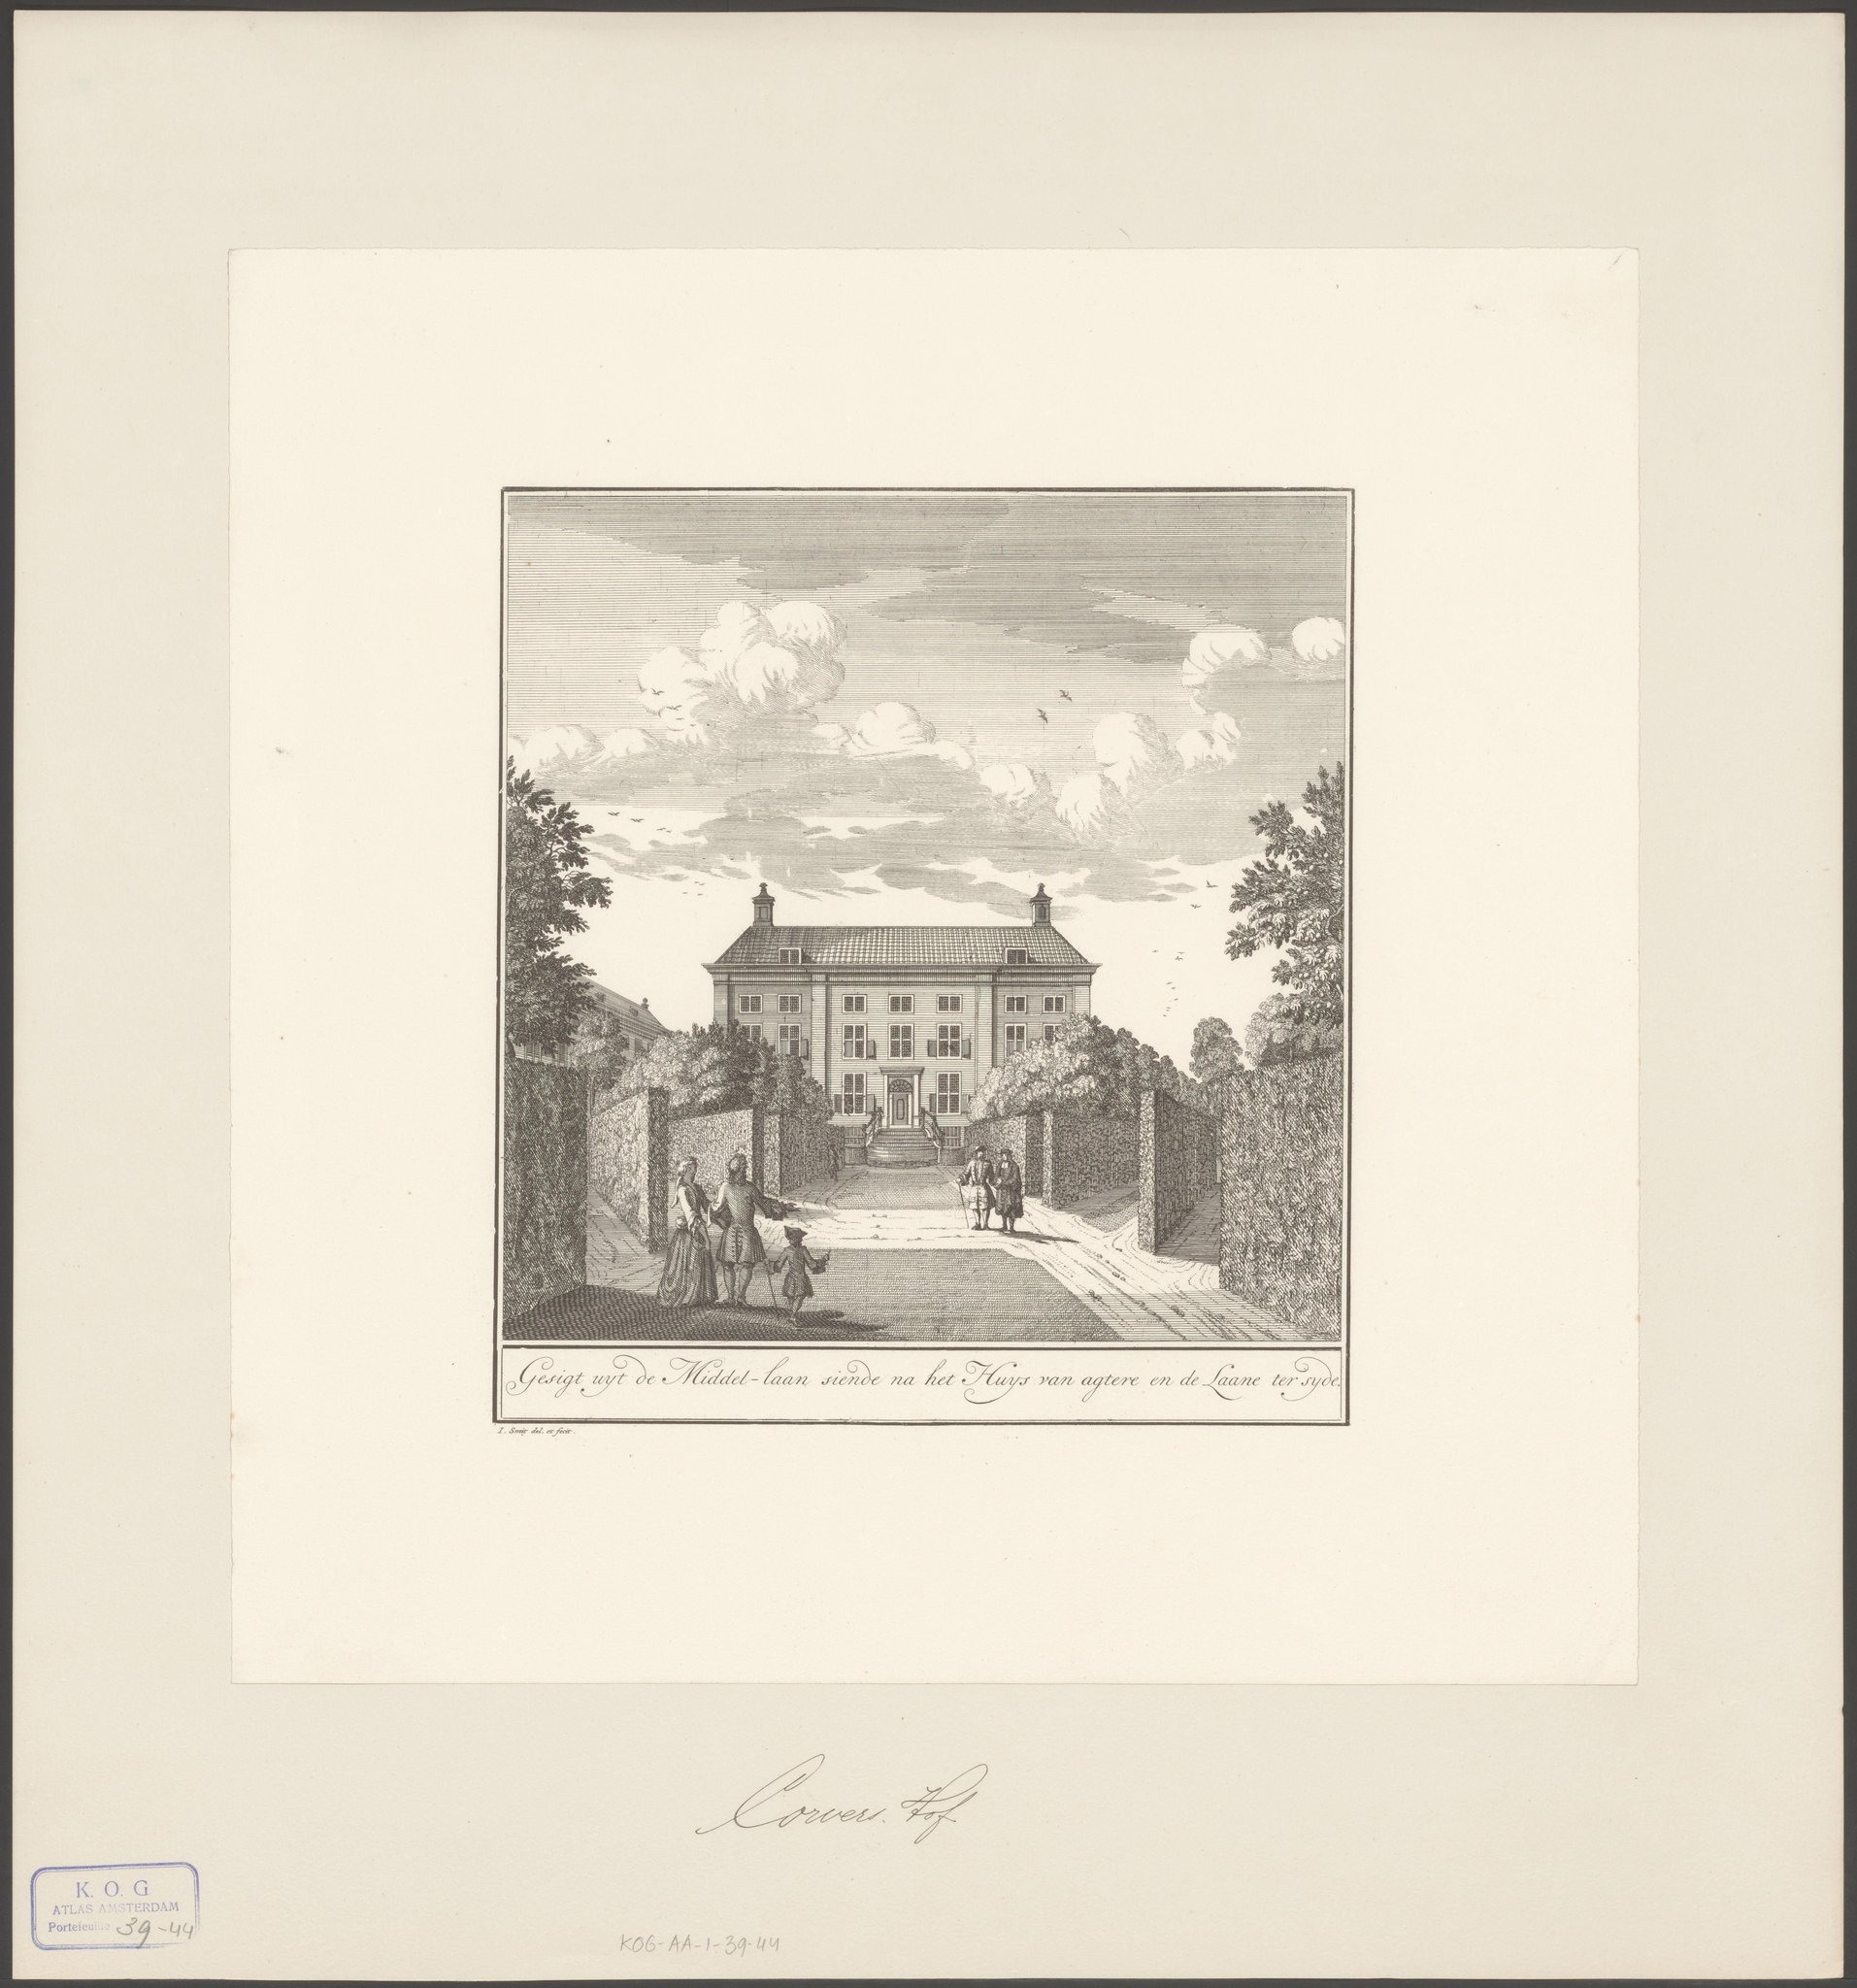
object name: photomechanical print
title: Gesigt uyt de Middel-laan siende na het Huys van agtere en de Laane ter syde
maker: Anonymous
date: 1855-1940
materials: paper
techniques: photolithography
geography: northern netherlands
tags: alms-house (dutch: 'hofje'), french or architectonic garden; formal garden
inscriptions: collector's mark: Lugt 1641b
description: Onderwerpsrubriek binnen de Atlas Amsterdam: Armwezen en liefdadige instellingen: III. Verschillende gestichten en instellingen / Hofjes: Corvershof der N. Hervormde Gemeente.